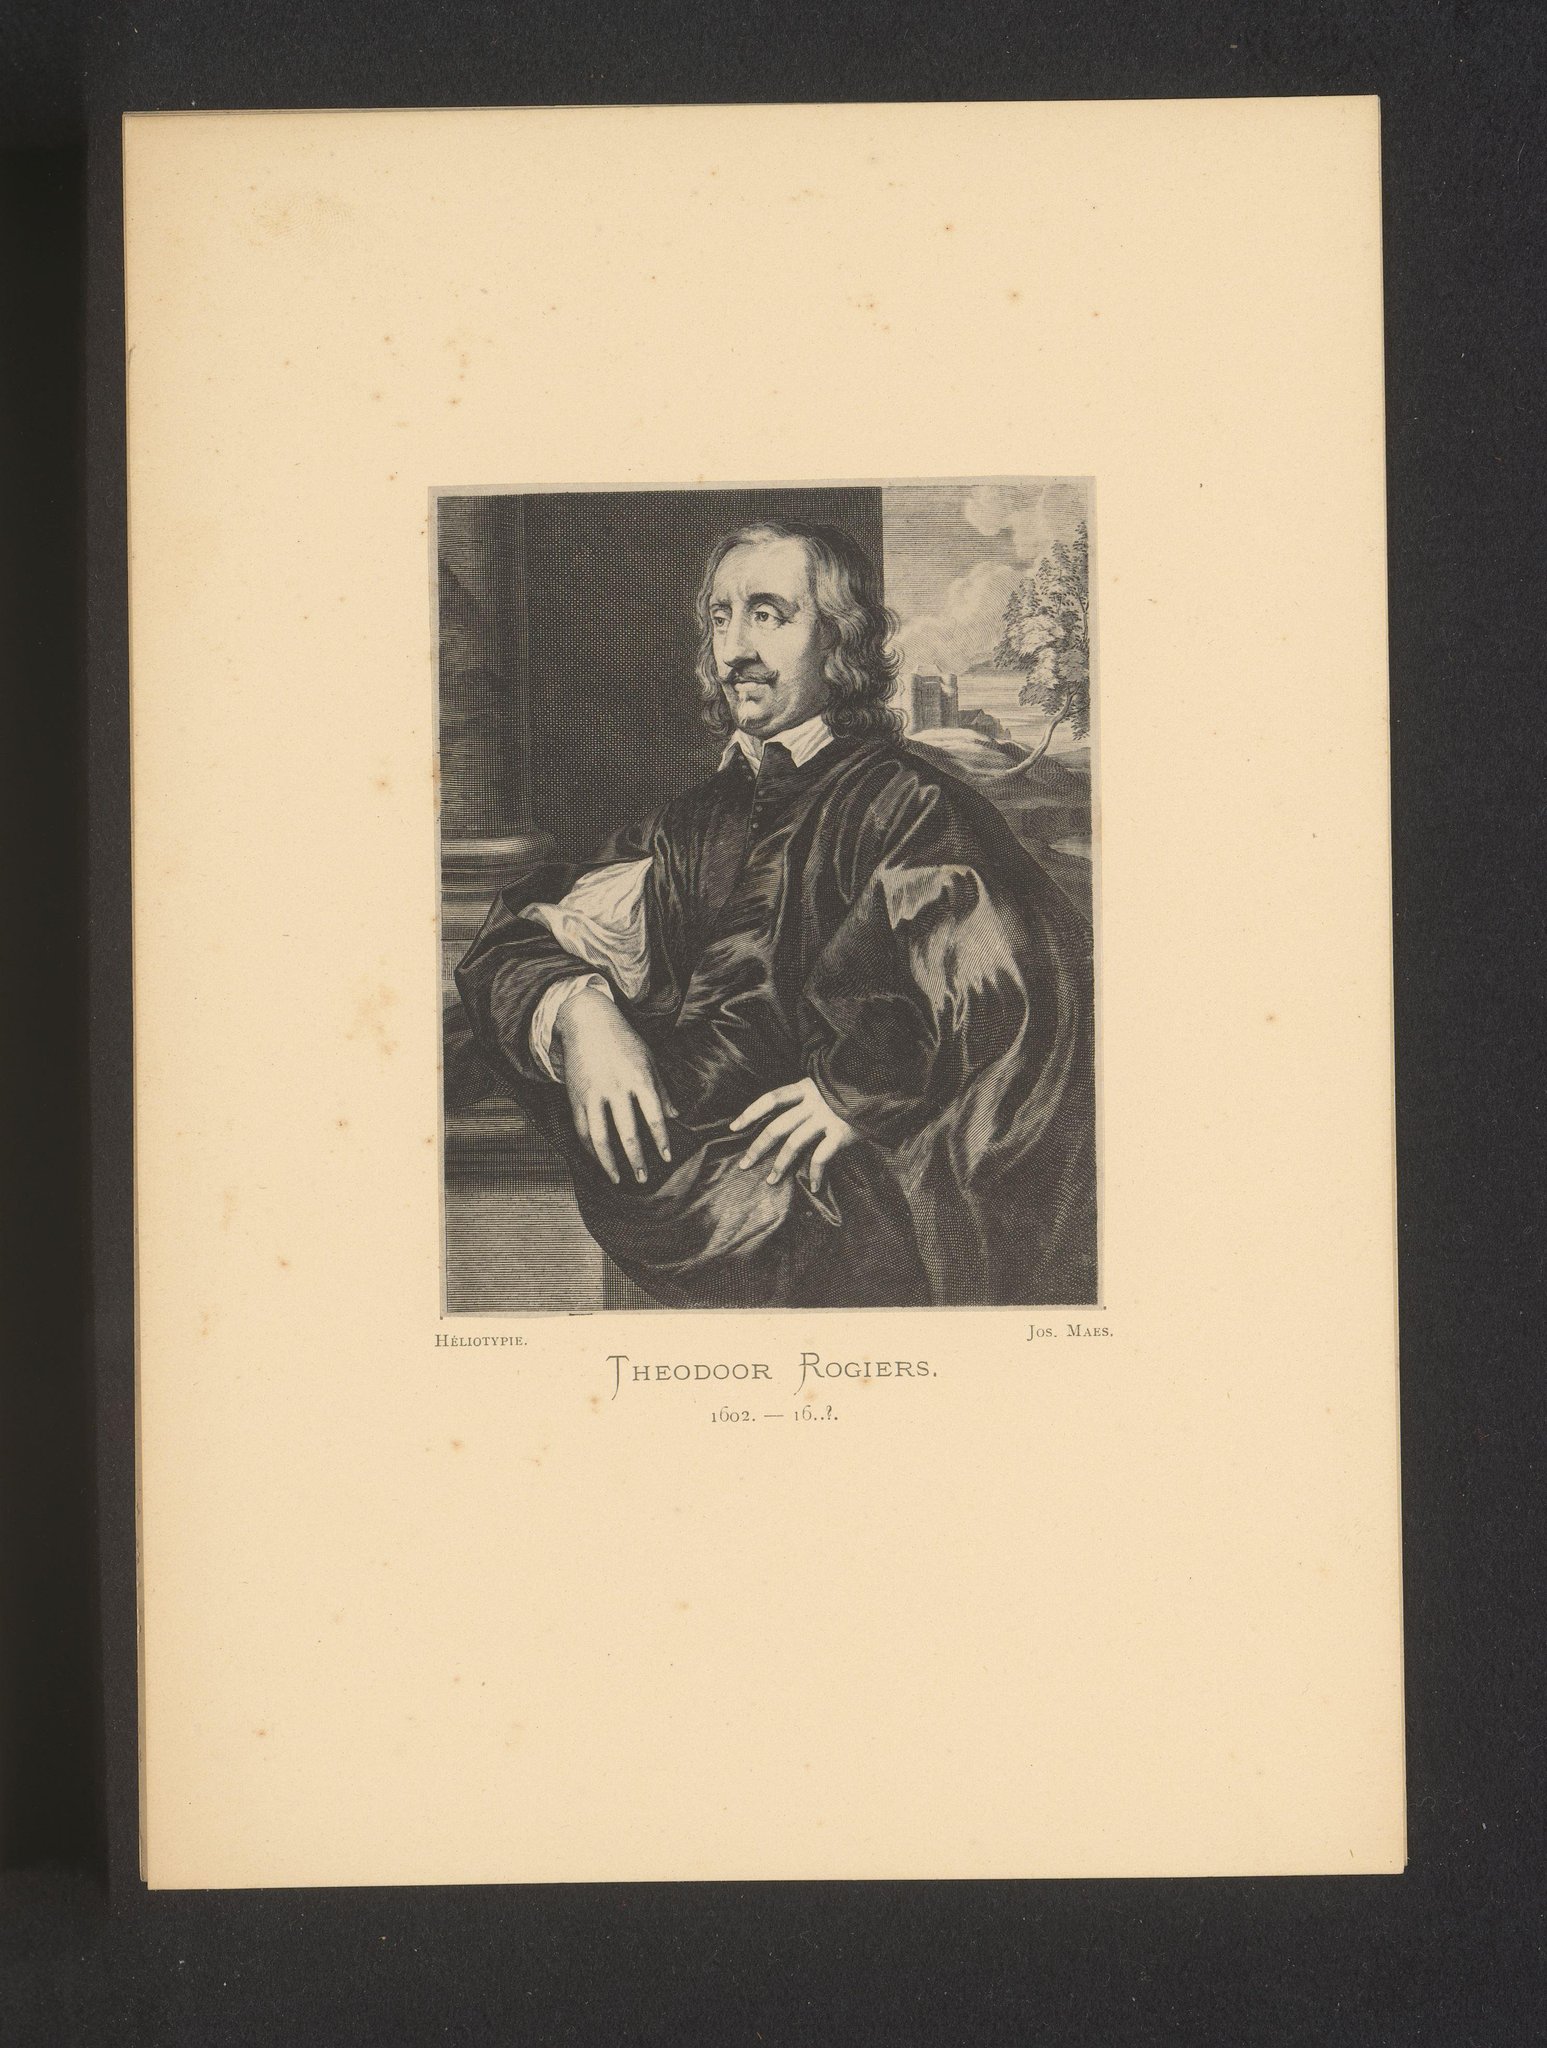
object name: photomechanical print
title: Reproductie van een gravure van een portret van Theodoor Rogiers door Petrus Clouwet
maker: joseph maes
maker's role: fotograaf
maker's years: 1838-1908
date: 1872-1877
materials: cardboard, paper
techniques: photograph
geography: antwerp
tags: silversmith, theodoor rogiers, historical persons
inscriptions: inscription: ‘1602. - 16..?.’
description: Deze prent maakt deel uit van een omslag met 150 prenten en een katern met een lijst van afbeeldingen.